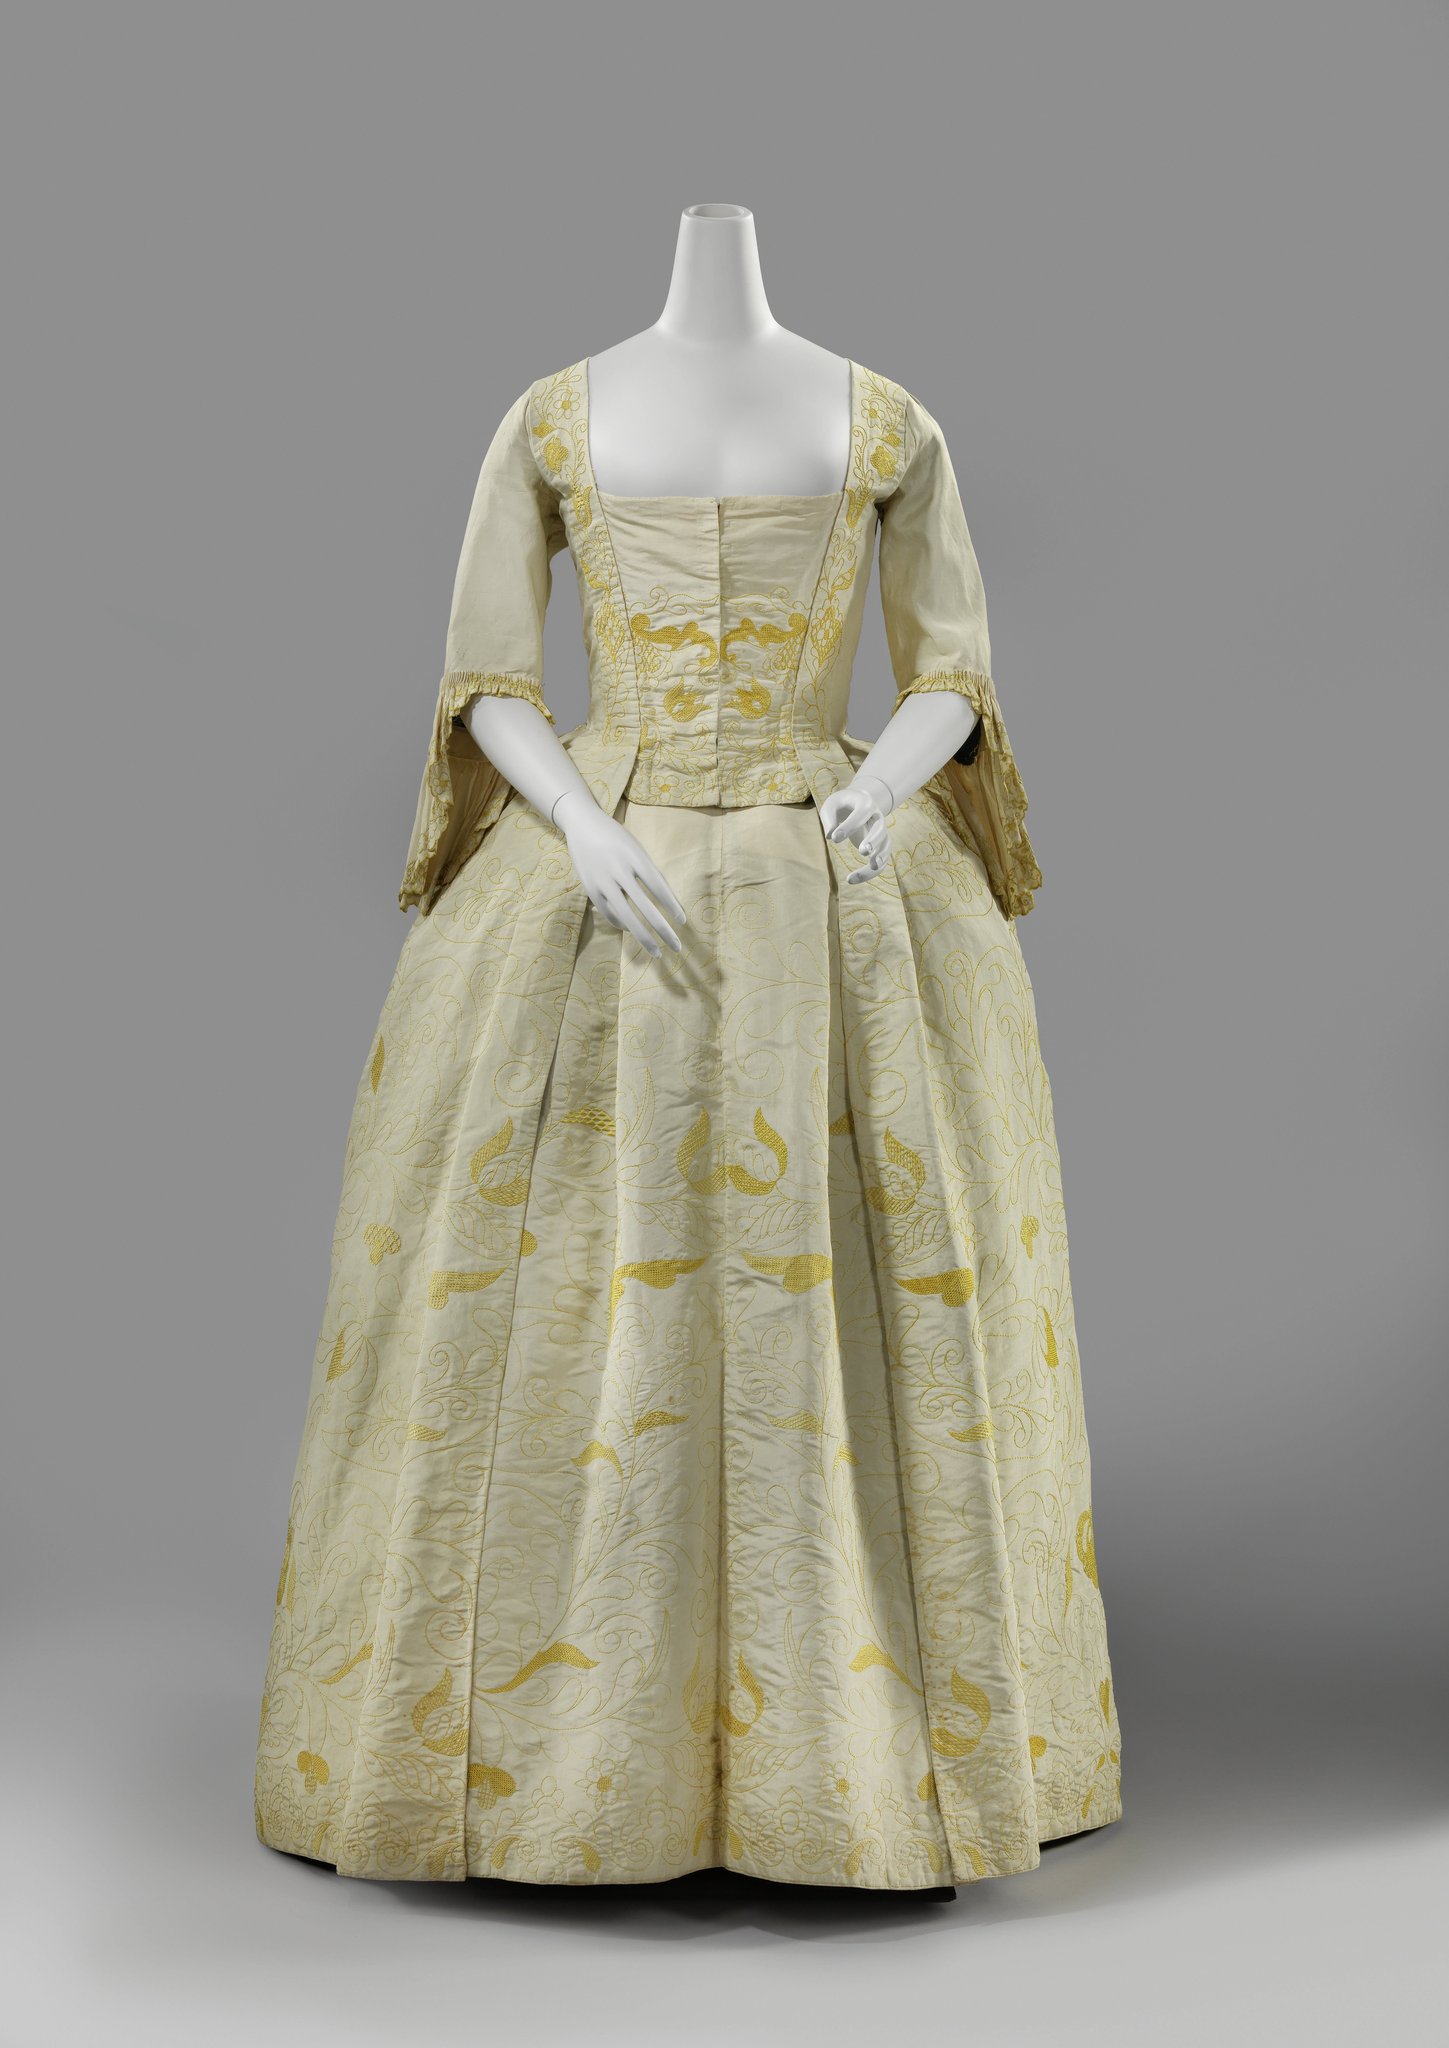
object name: tablier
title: Tablier, rondom geplooid met brede middenplooi van crèmekleurige zijde in geel geborduurd met ranke, breed uitgemeten bloem- en bladranken; blauwe linnen voering.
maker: Anonymous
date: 1740-1745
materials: linen, silk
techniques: embroidered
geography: france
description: Gladde tablier met diepe plooien aan een band gezet; horend bij een japon van witte ripszijde, geborduurd met gele zijde.